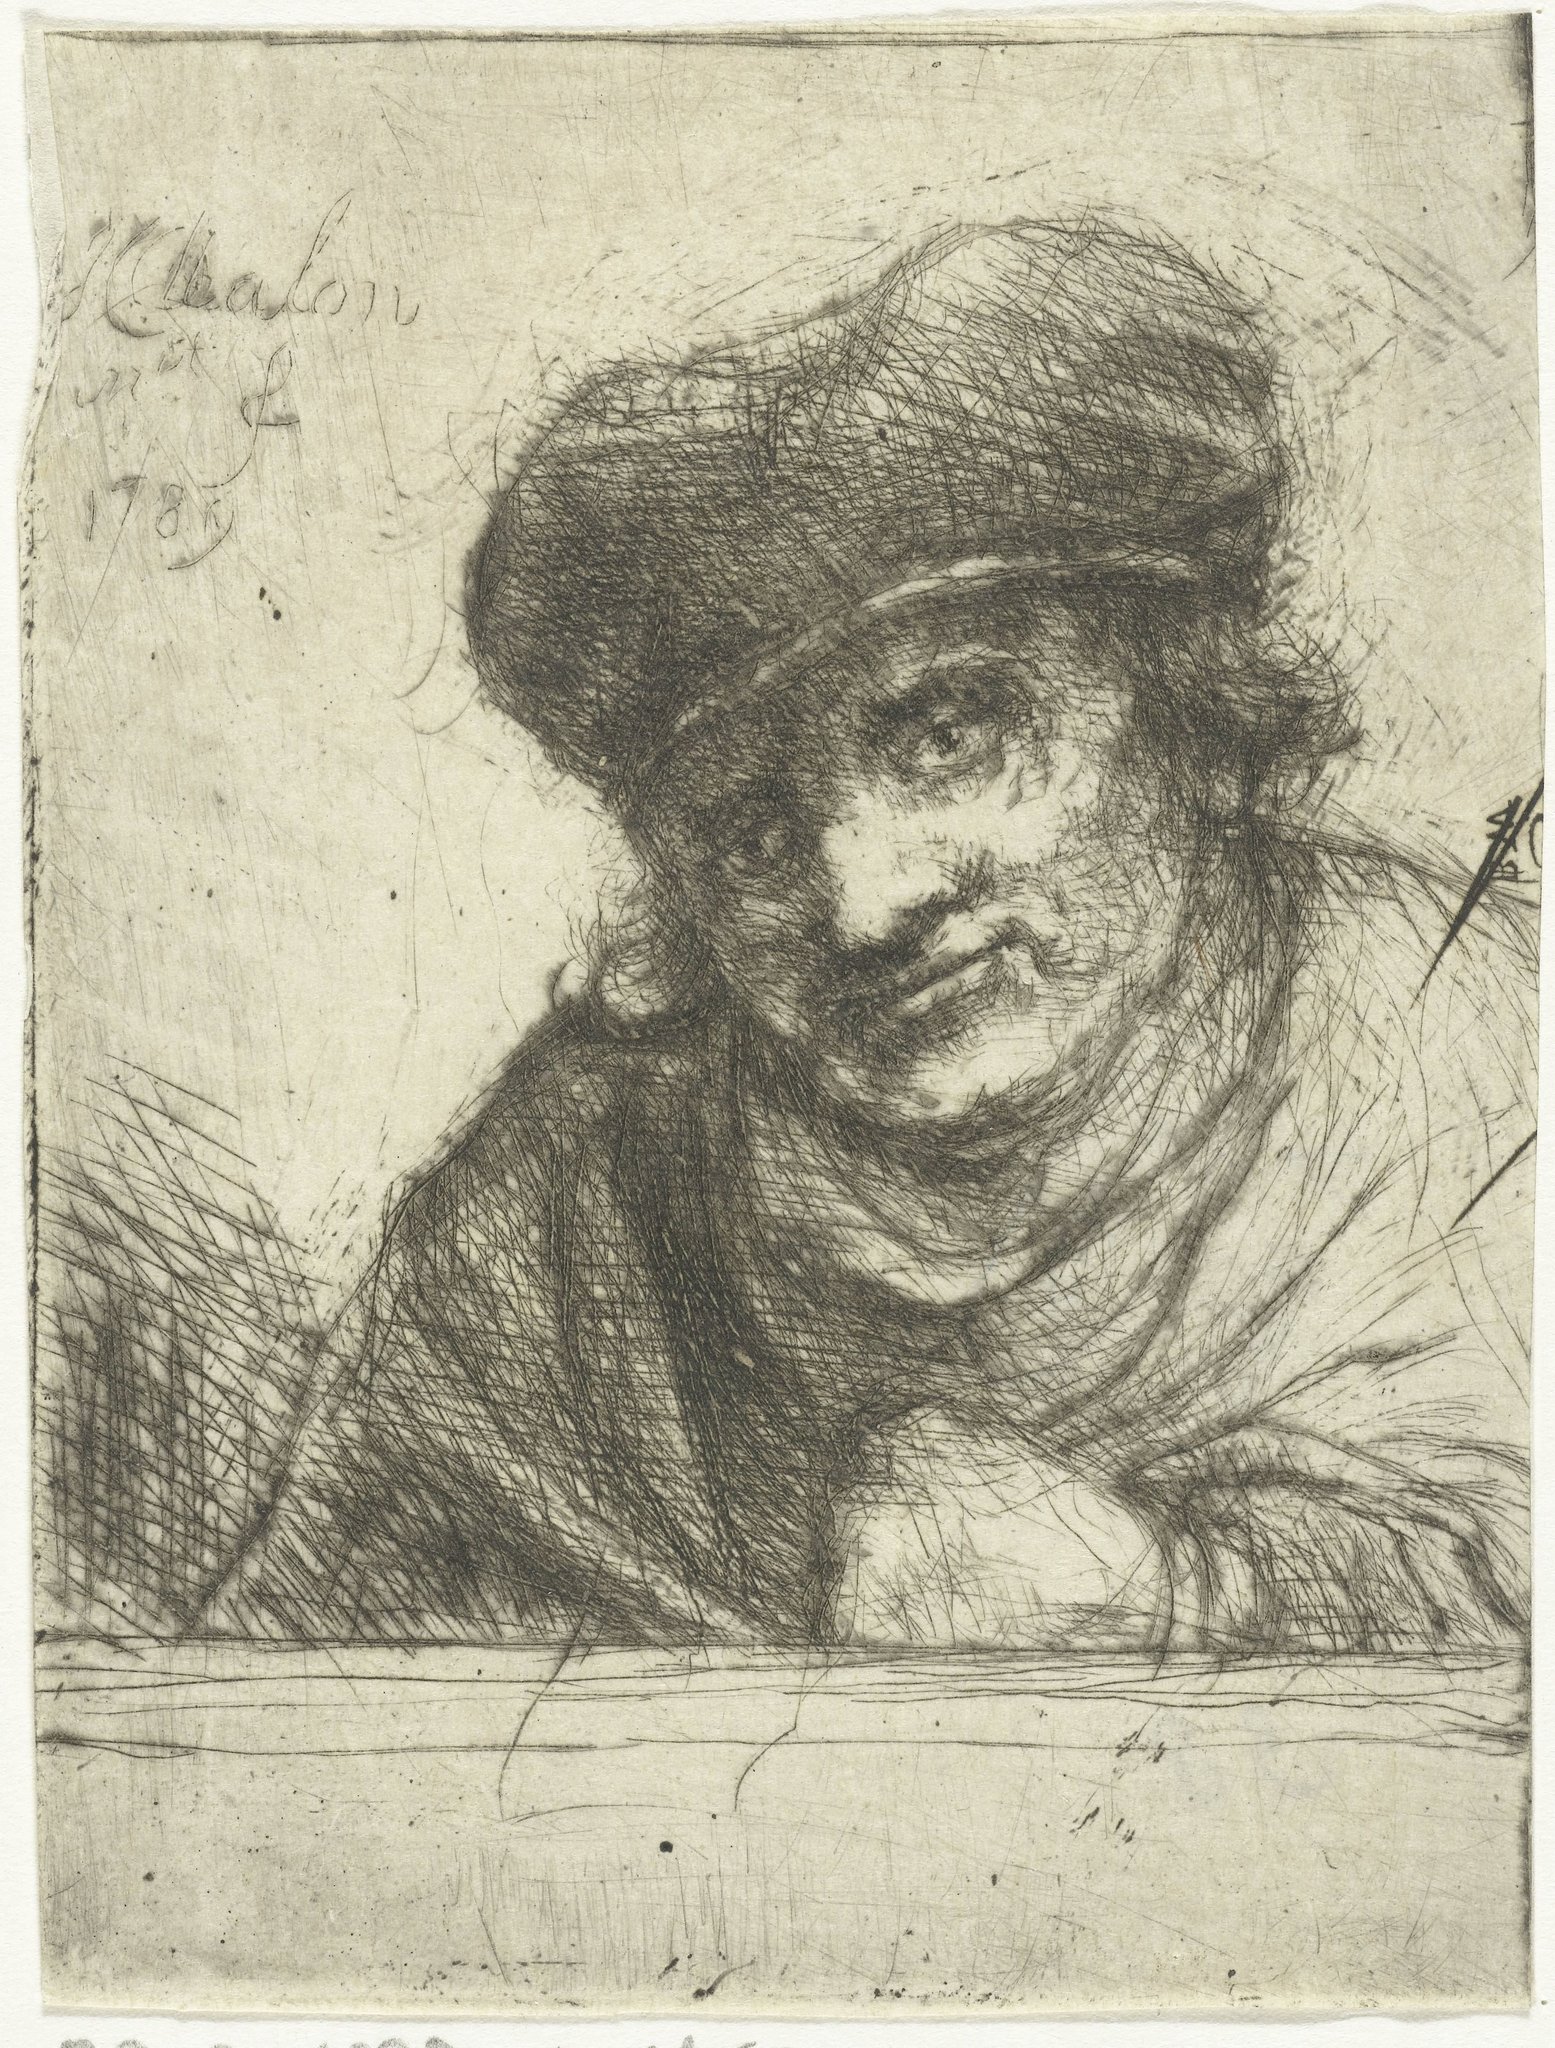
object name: print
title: Man met muts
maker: jan chalon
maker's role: print maker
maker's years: 1738-1795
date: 1789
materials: paper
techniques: drypoint, etching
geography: northern netherlands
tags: head-gear: cap (+ men's clothes), morphology of human expression (+ adult male (human being))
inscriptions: date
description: Een volwassen man met muts. Buste naar links